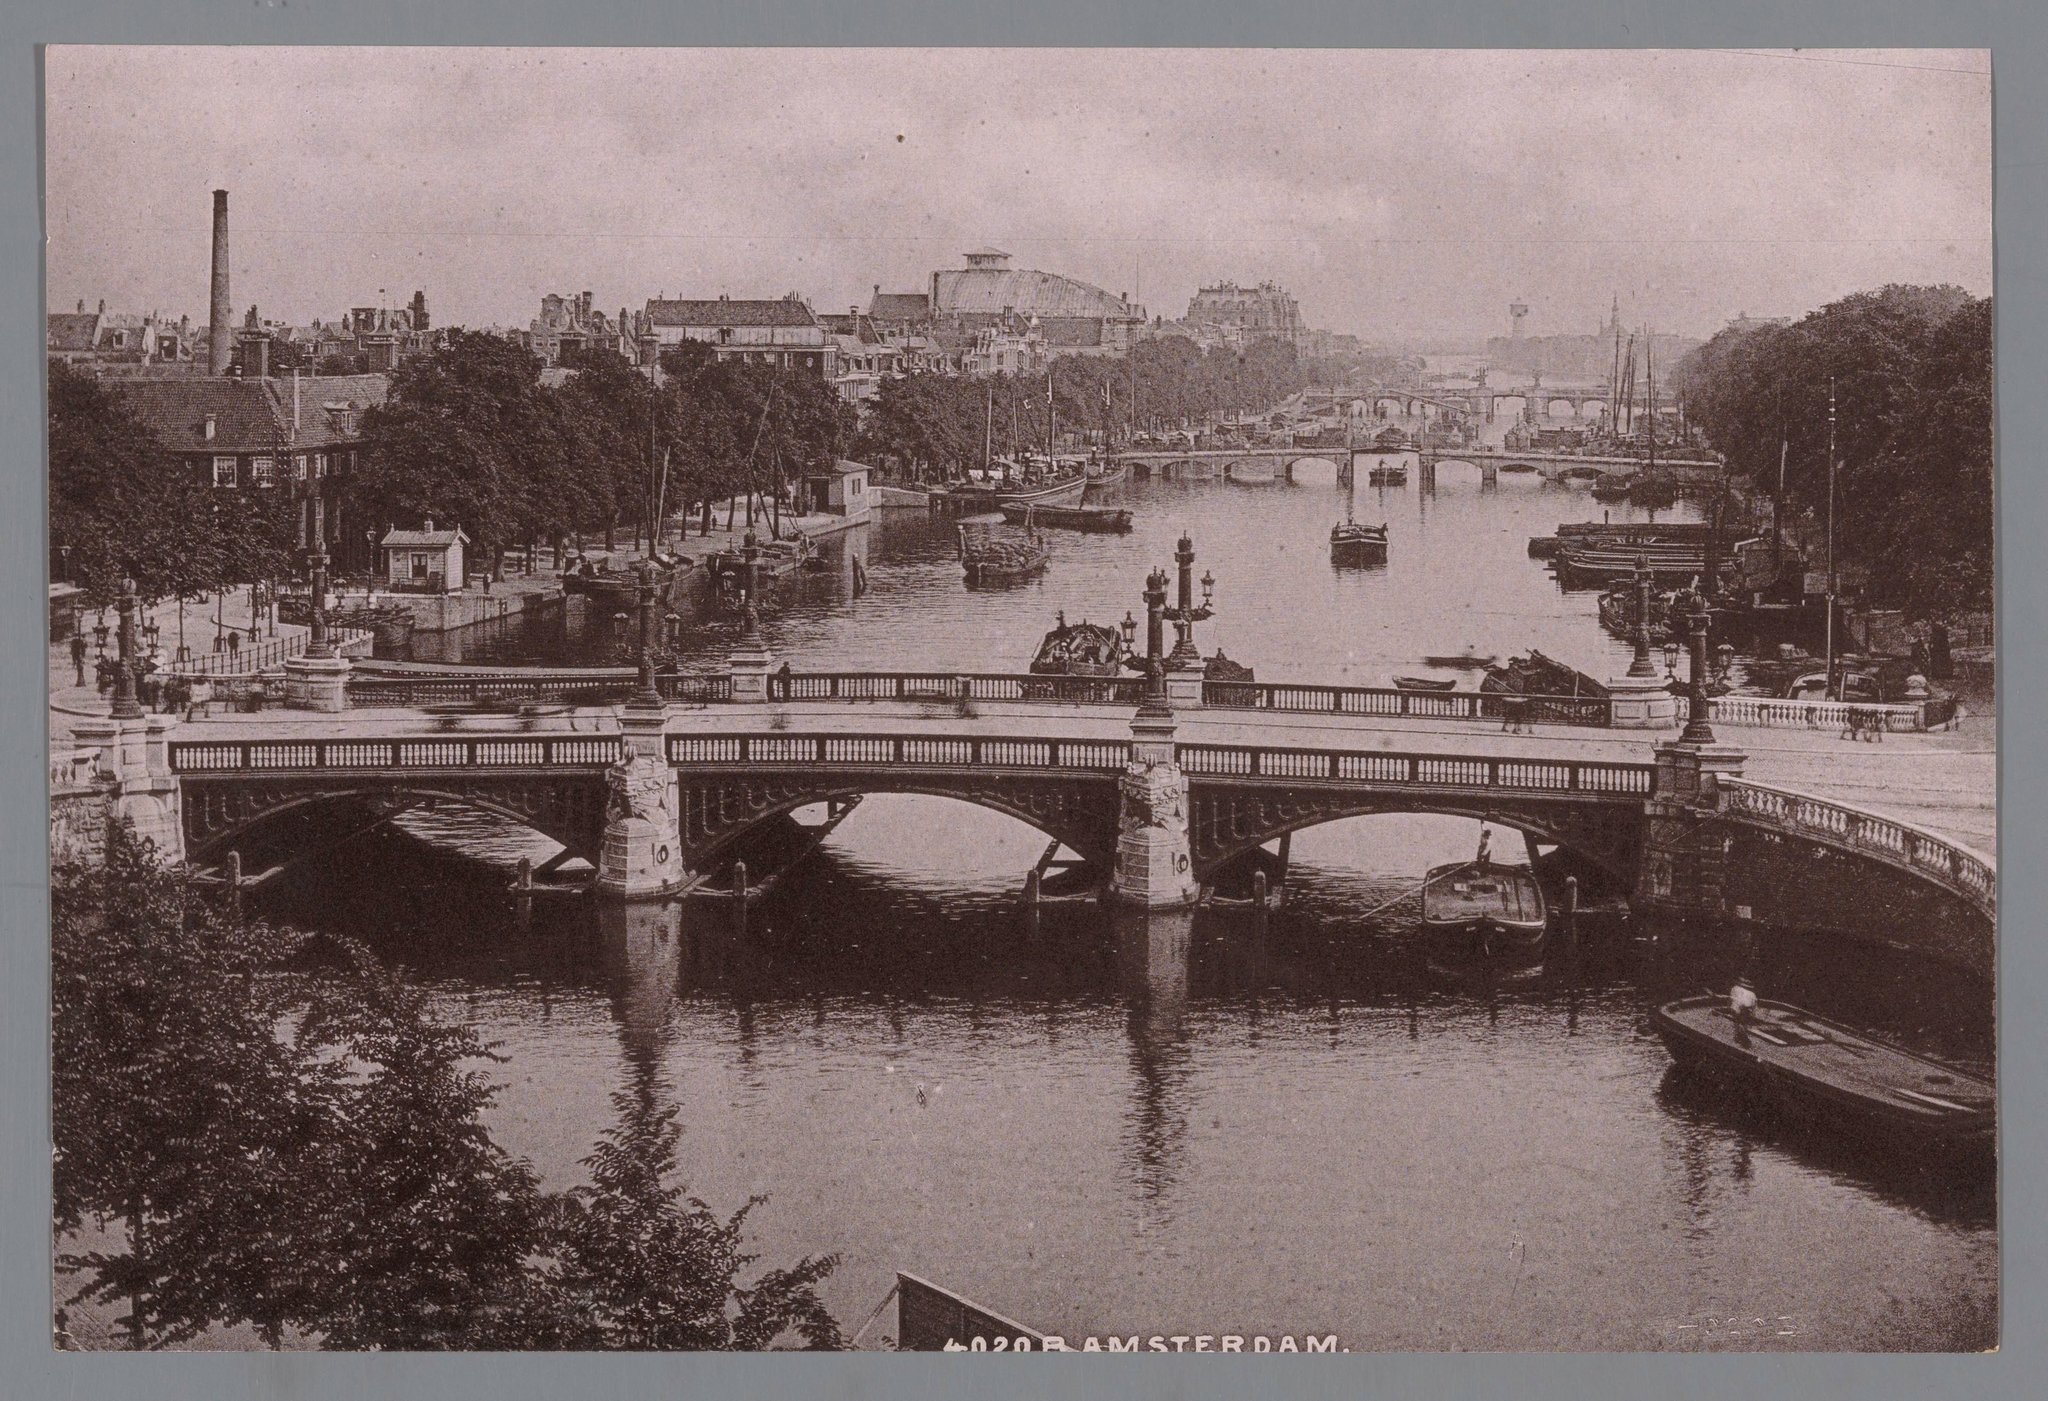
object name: photomechanical print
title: Gezicht op de Blauwbrug over de Amstel te Amsterdam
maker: Anonymous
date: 1883-1890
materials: paper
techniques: photograph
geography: amsterdam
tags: city-view in general; 'veduta', canals, waters (in city), bridge in city across river, canal, etc.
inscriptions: number: ‘4020B’, inscription: ‘AMSTERDAM’